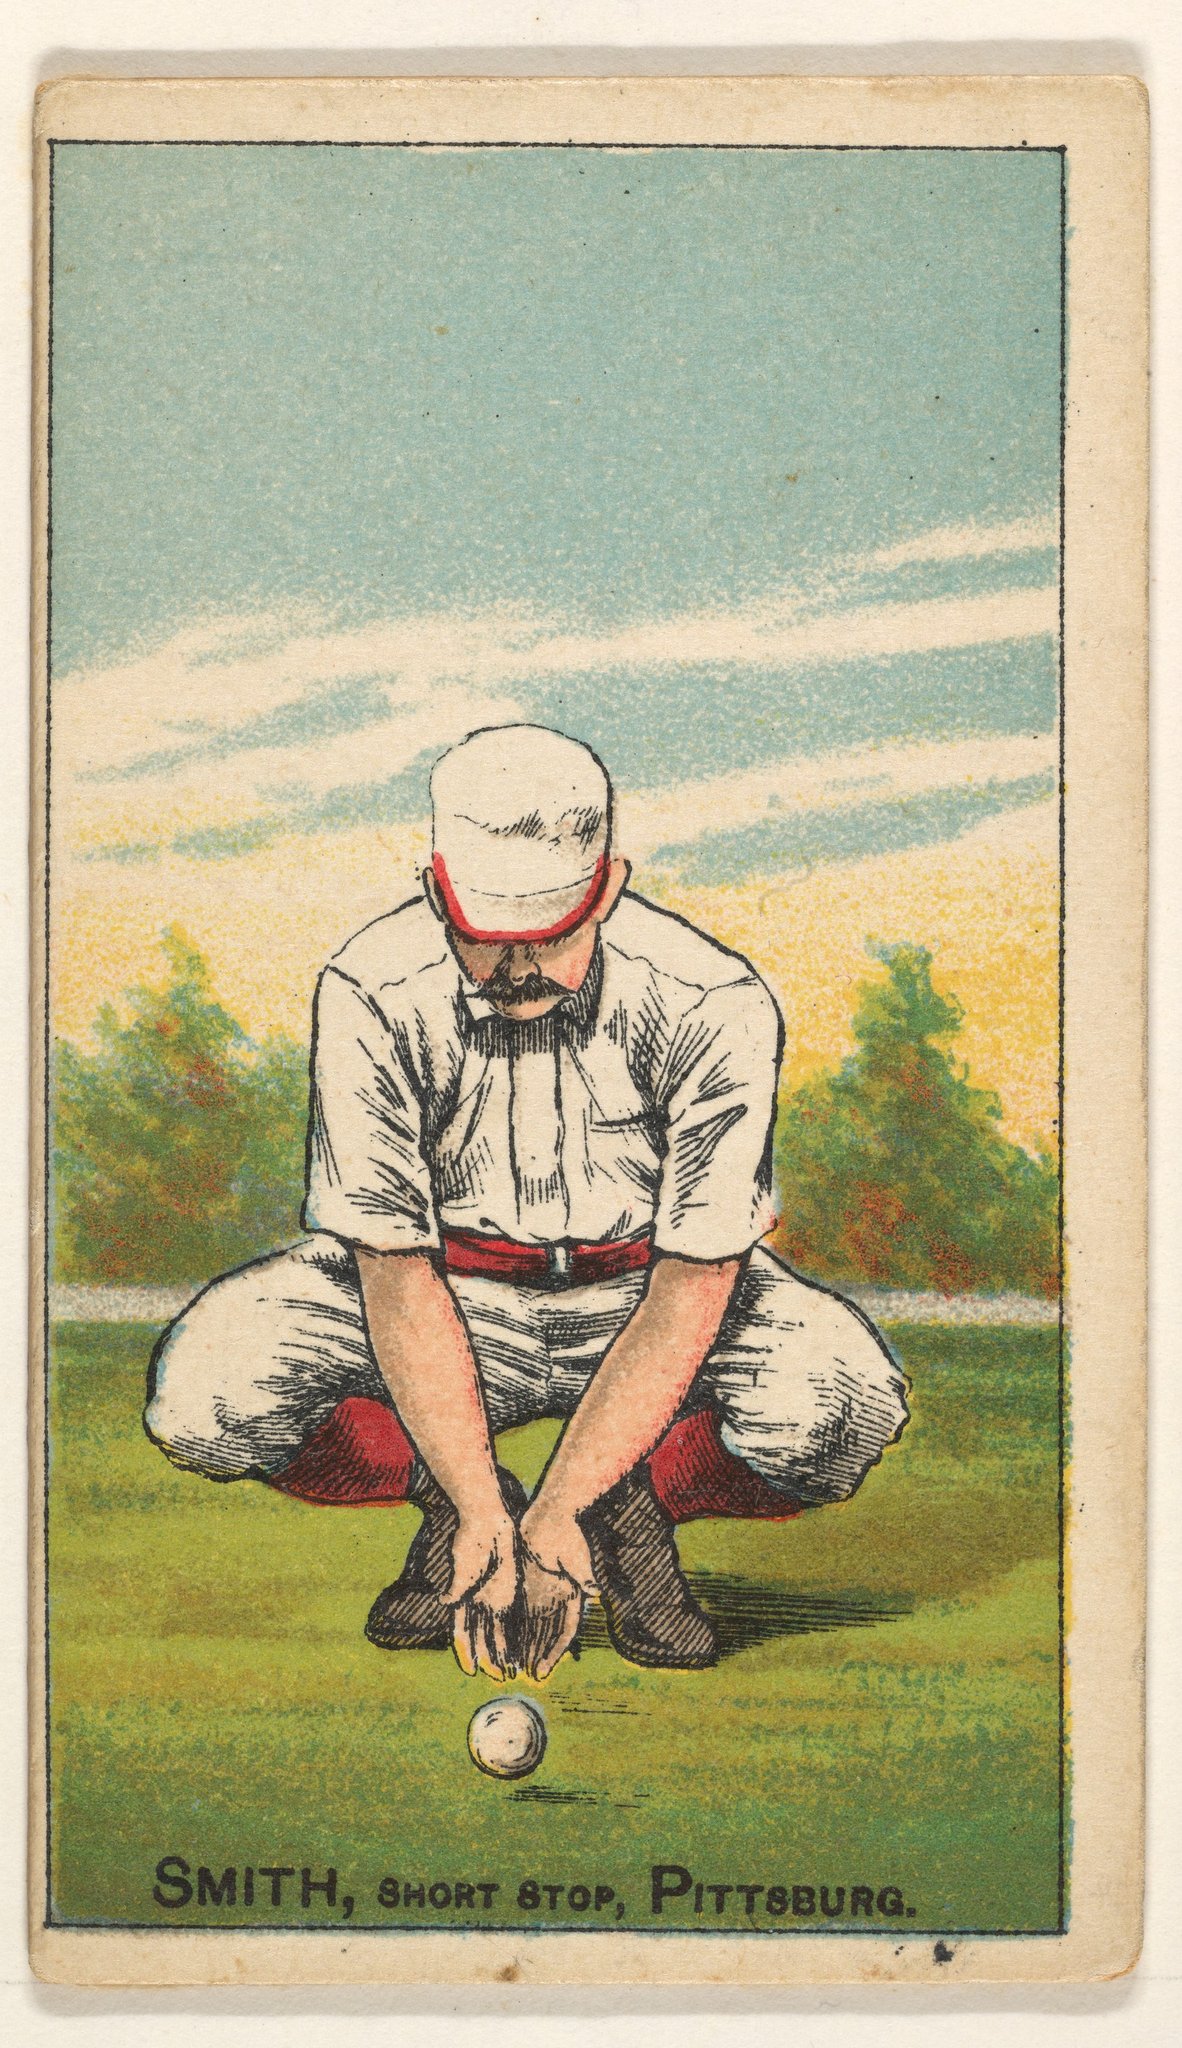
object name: baseball card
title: Smith, Shortstop, Pittsburgh, from the Gold Coin series (N284) for Gold Coin Chewing Tobacco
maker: d. buchner & co., new york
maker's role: publisher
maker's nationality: american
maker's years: 1850-1900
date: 1887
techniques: color lithograph, drawing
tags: men,baseball,athletes